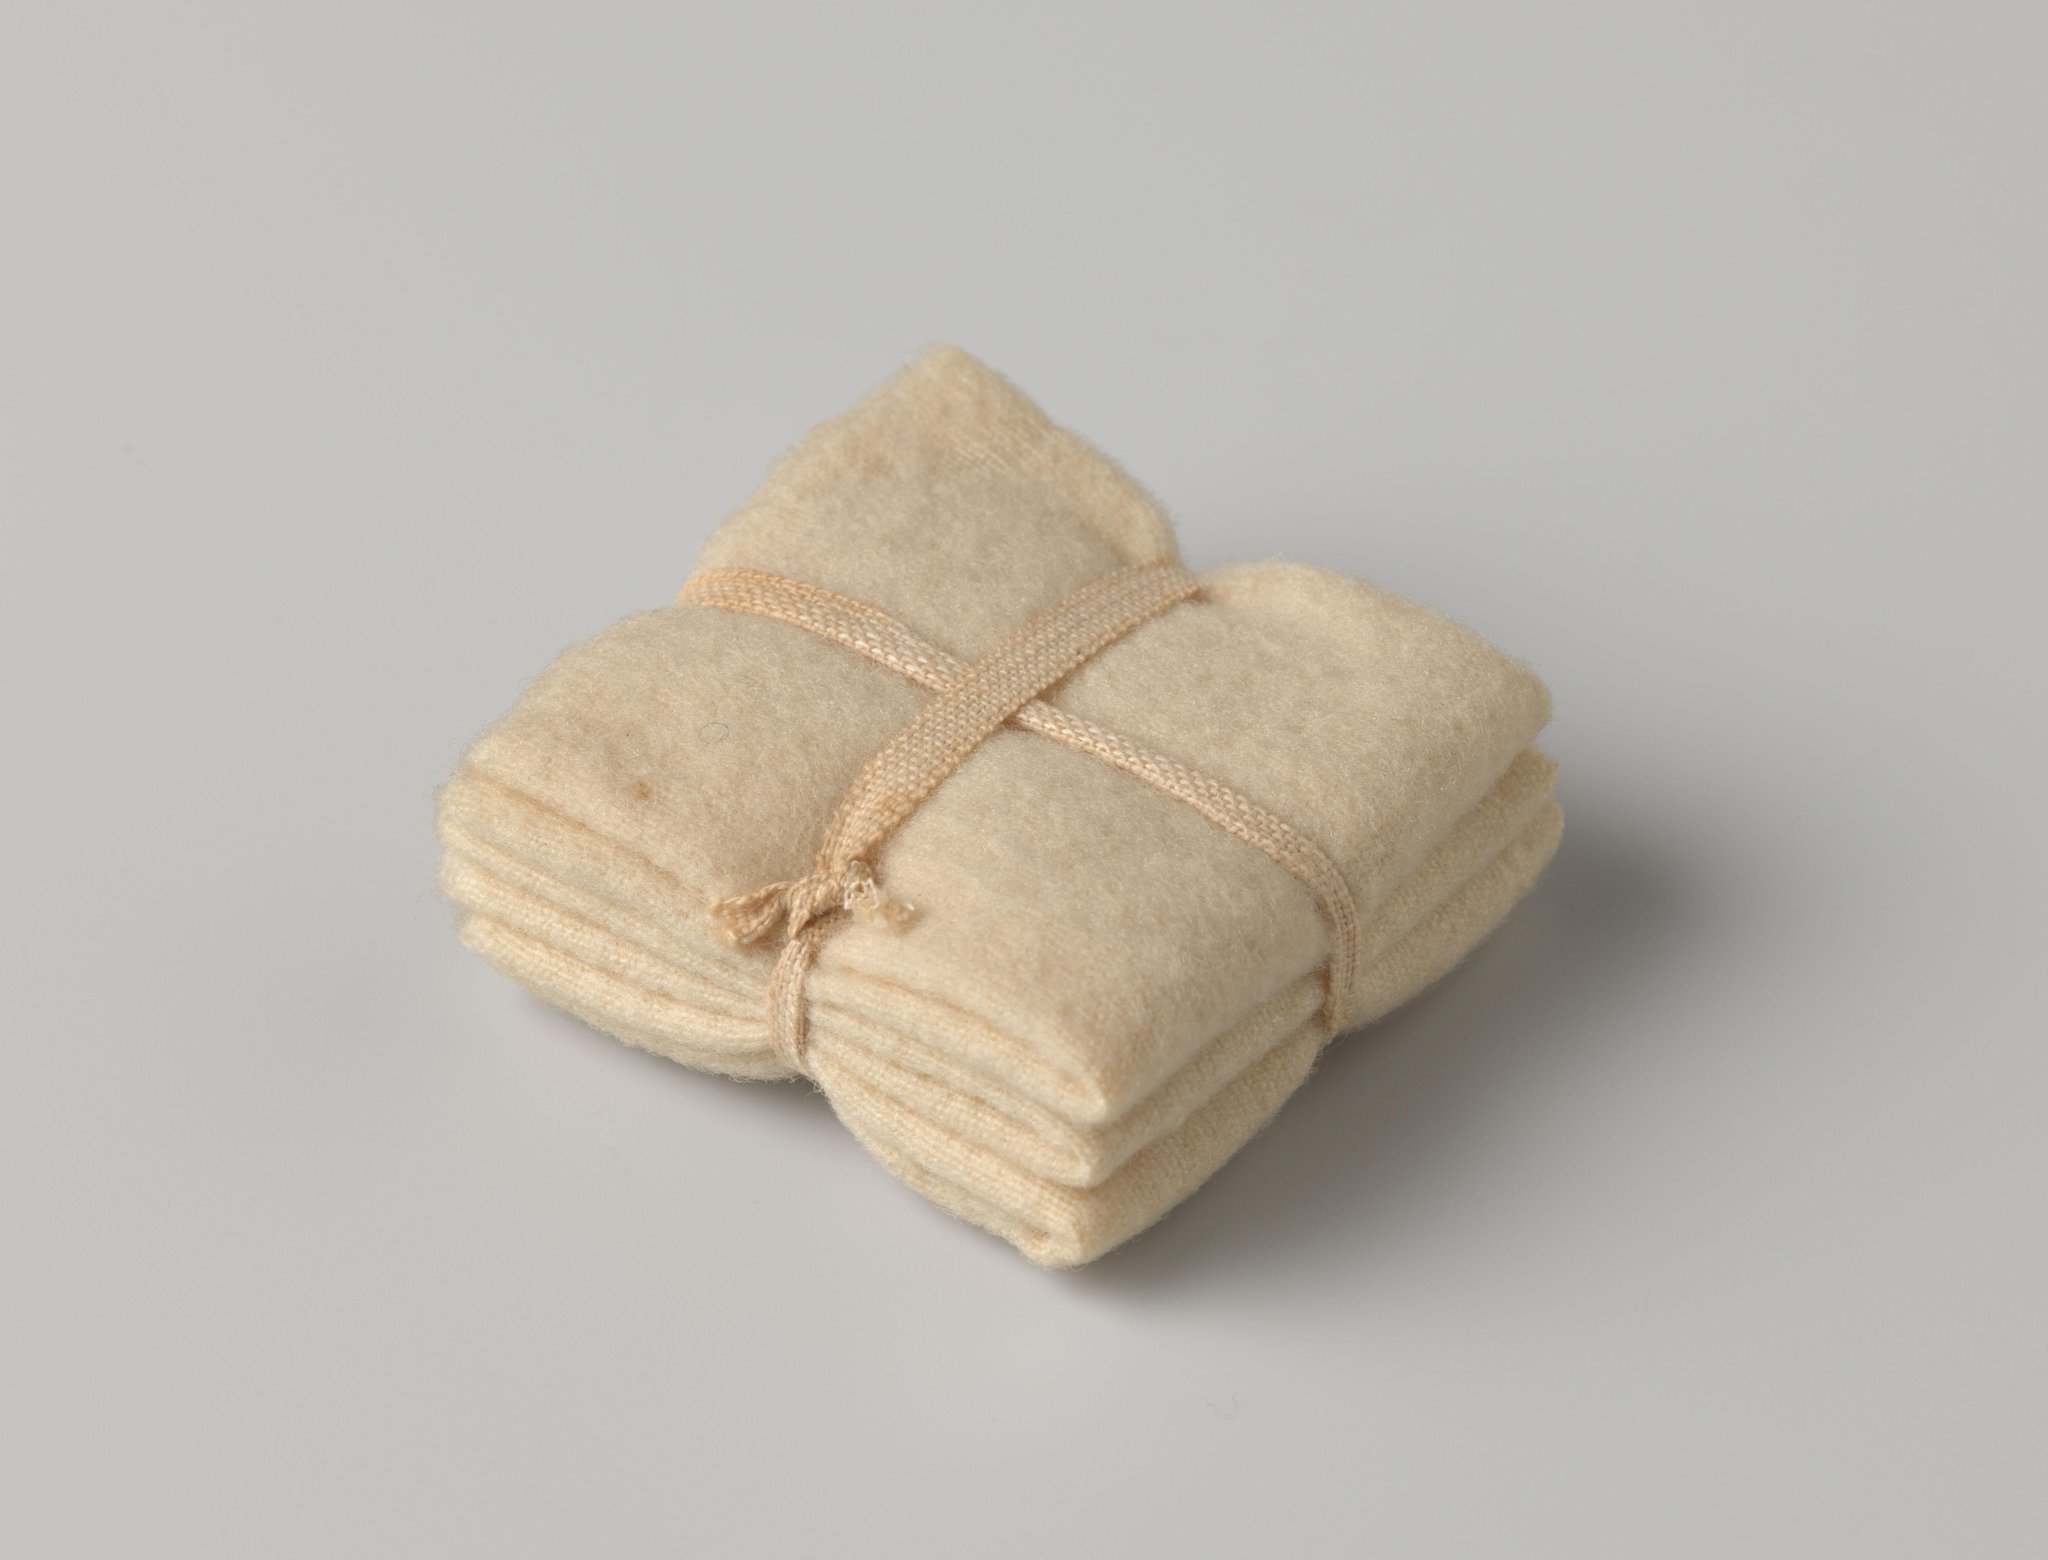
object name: miniature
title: Stapel dekens, samengebonden met een band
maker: Anonymous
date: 1750-1800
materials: linen, wool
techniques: napping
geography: netherlands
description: Een stapel van drie opgevouwen en samengebonden wollen dekens (?) gebundeld met linnen band.